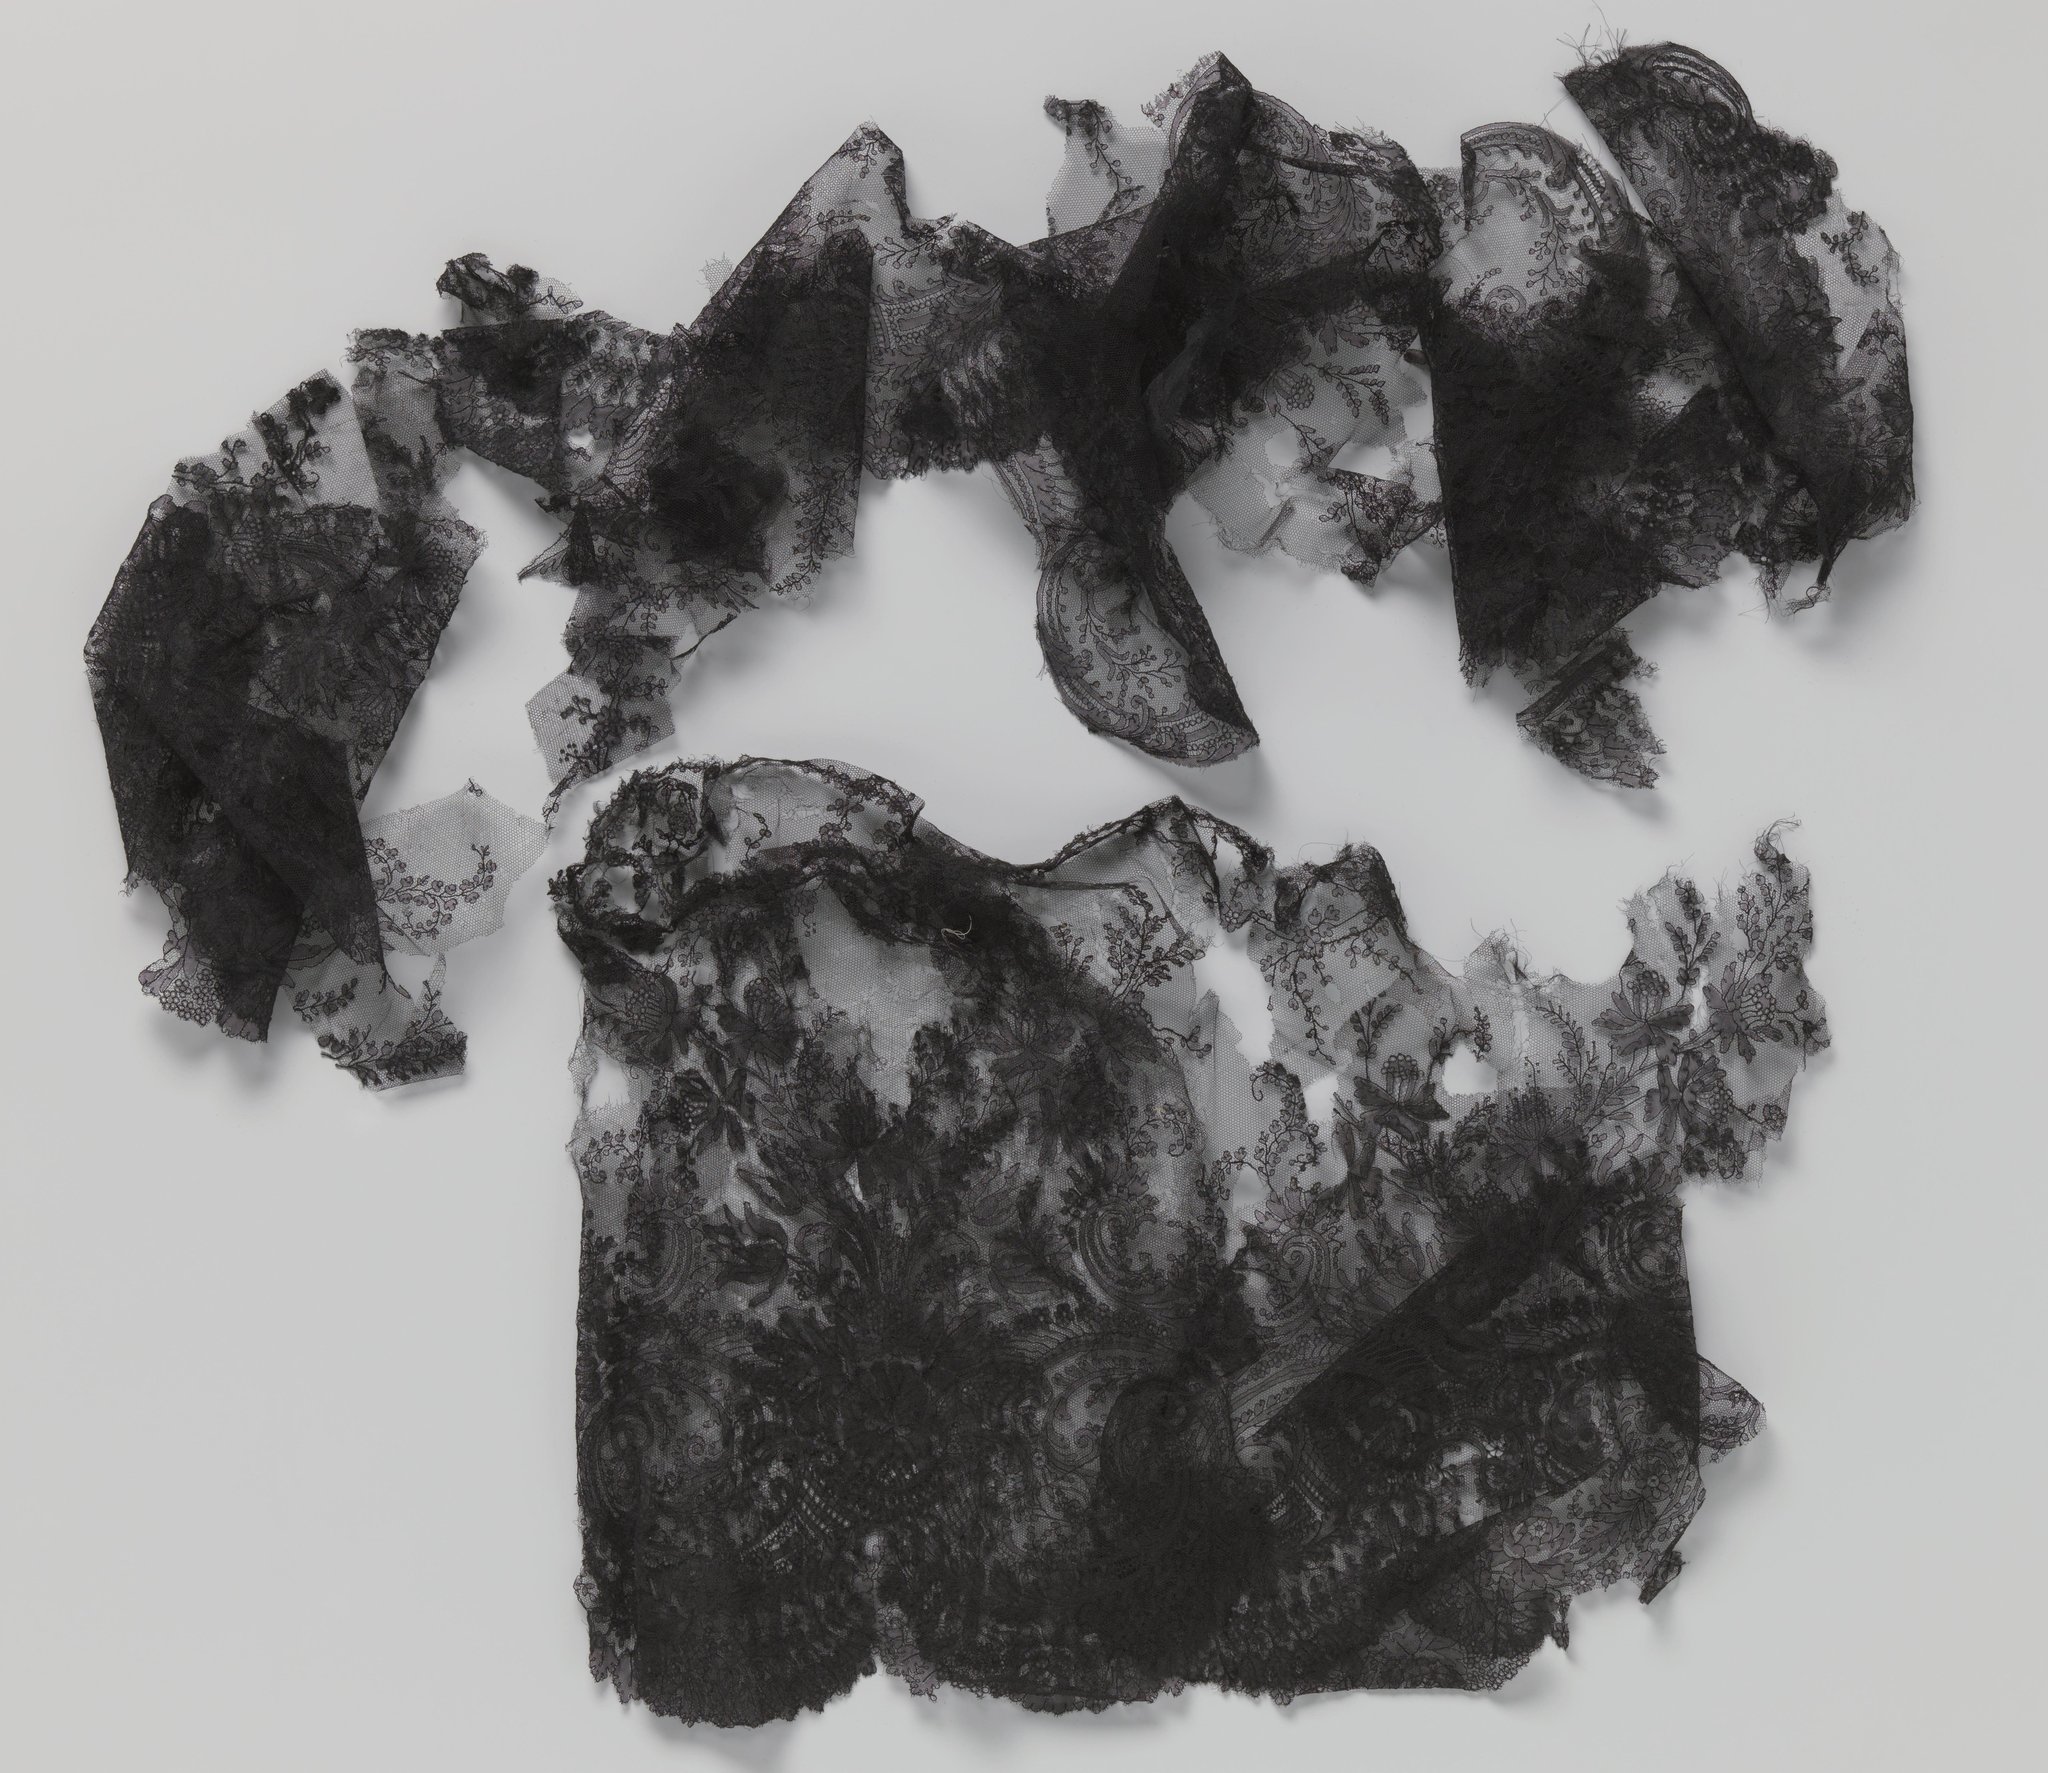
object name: strip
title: Fragmenten van een strook kloskant met hoorns van overvloed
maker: Anonymous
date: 1850-1860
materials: silk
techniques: lace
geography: caen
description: Fragmenten van een strook zwarte kloskant: Chantilly-kant. Het oorspronkelijke patroon bestaat uit een lege traliegrond waar langs de zware en breed geschulpte onderkant holle hoorns van overvloed liggen, waar kleinere hoorns uitschuiven, die gestuit worden door bolle c-voluten. Uit de hoorns rijzen gezwenkte takken op met anemonen, tulpen, narcissen en lelietjes van dalen. De schulpen vertonen beurtelings een waaier van blaadjes en een dikke guirlande van anemonen en andere bloemen. Van de binnenzijde met aaneengeschakelde rozetjes hangen fijne slingertjes met bloempjes af.